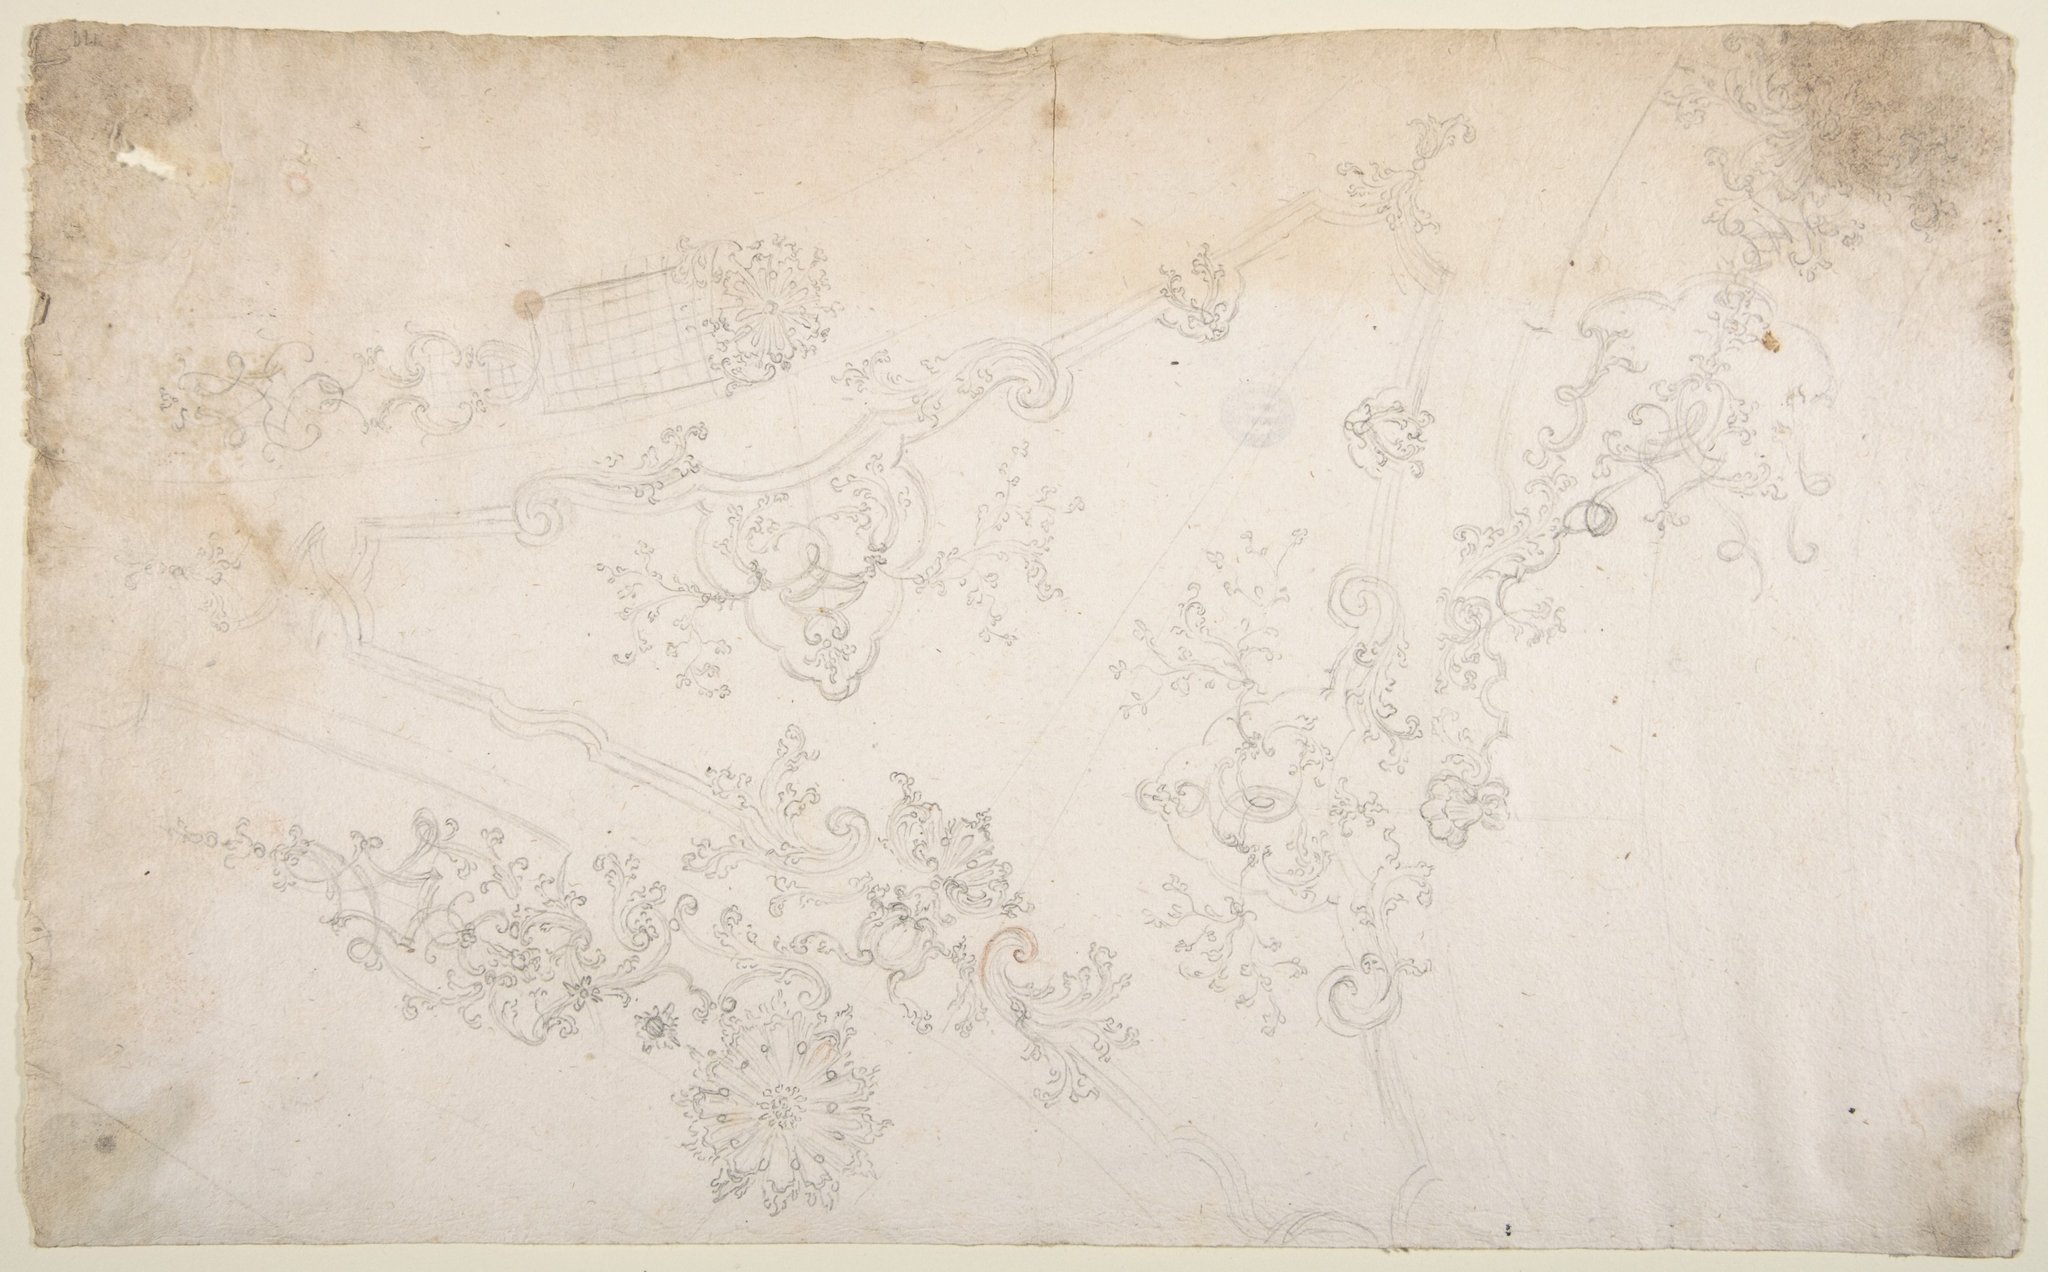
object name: drawing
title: Design for Ceiling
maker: leonardo marini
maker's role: artist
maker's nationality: italian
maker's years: 1730-1797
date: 1701-1800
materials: graphite, drawing material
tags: ceilings